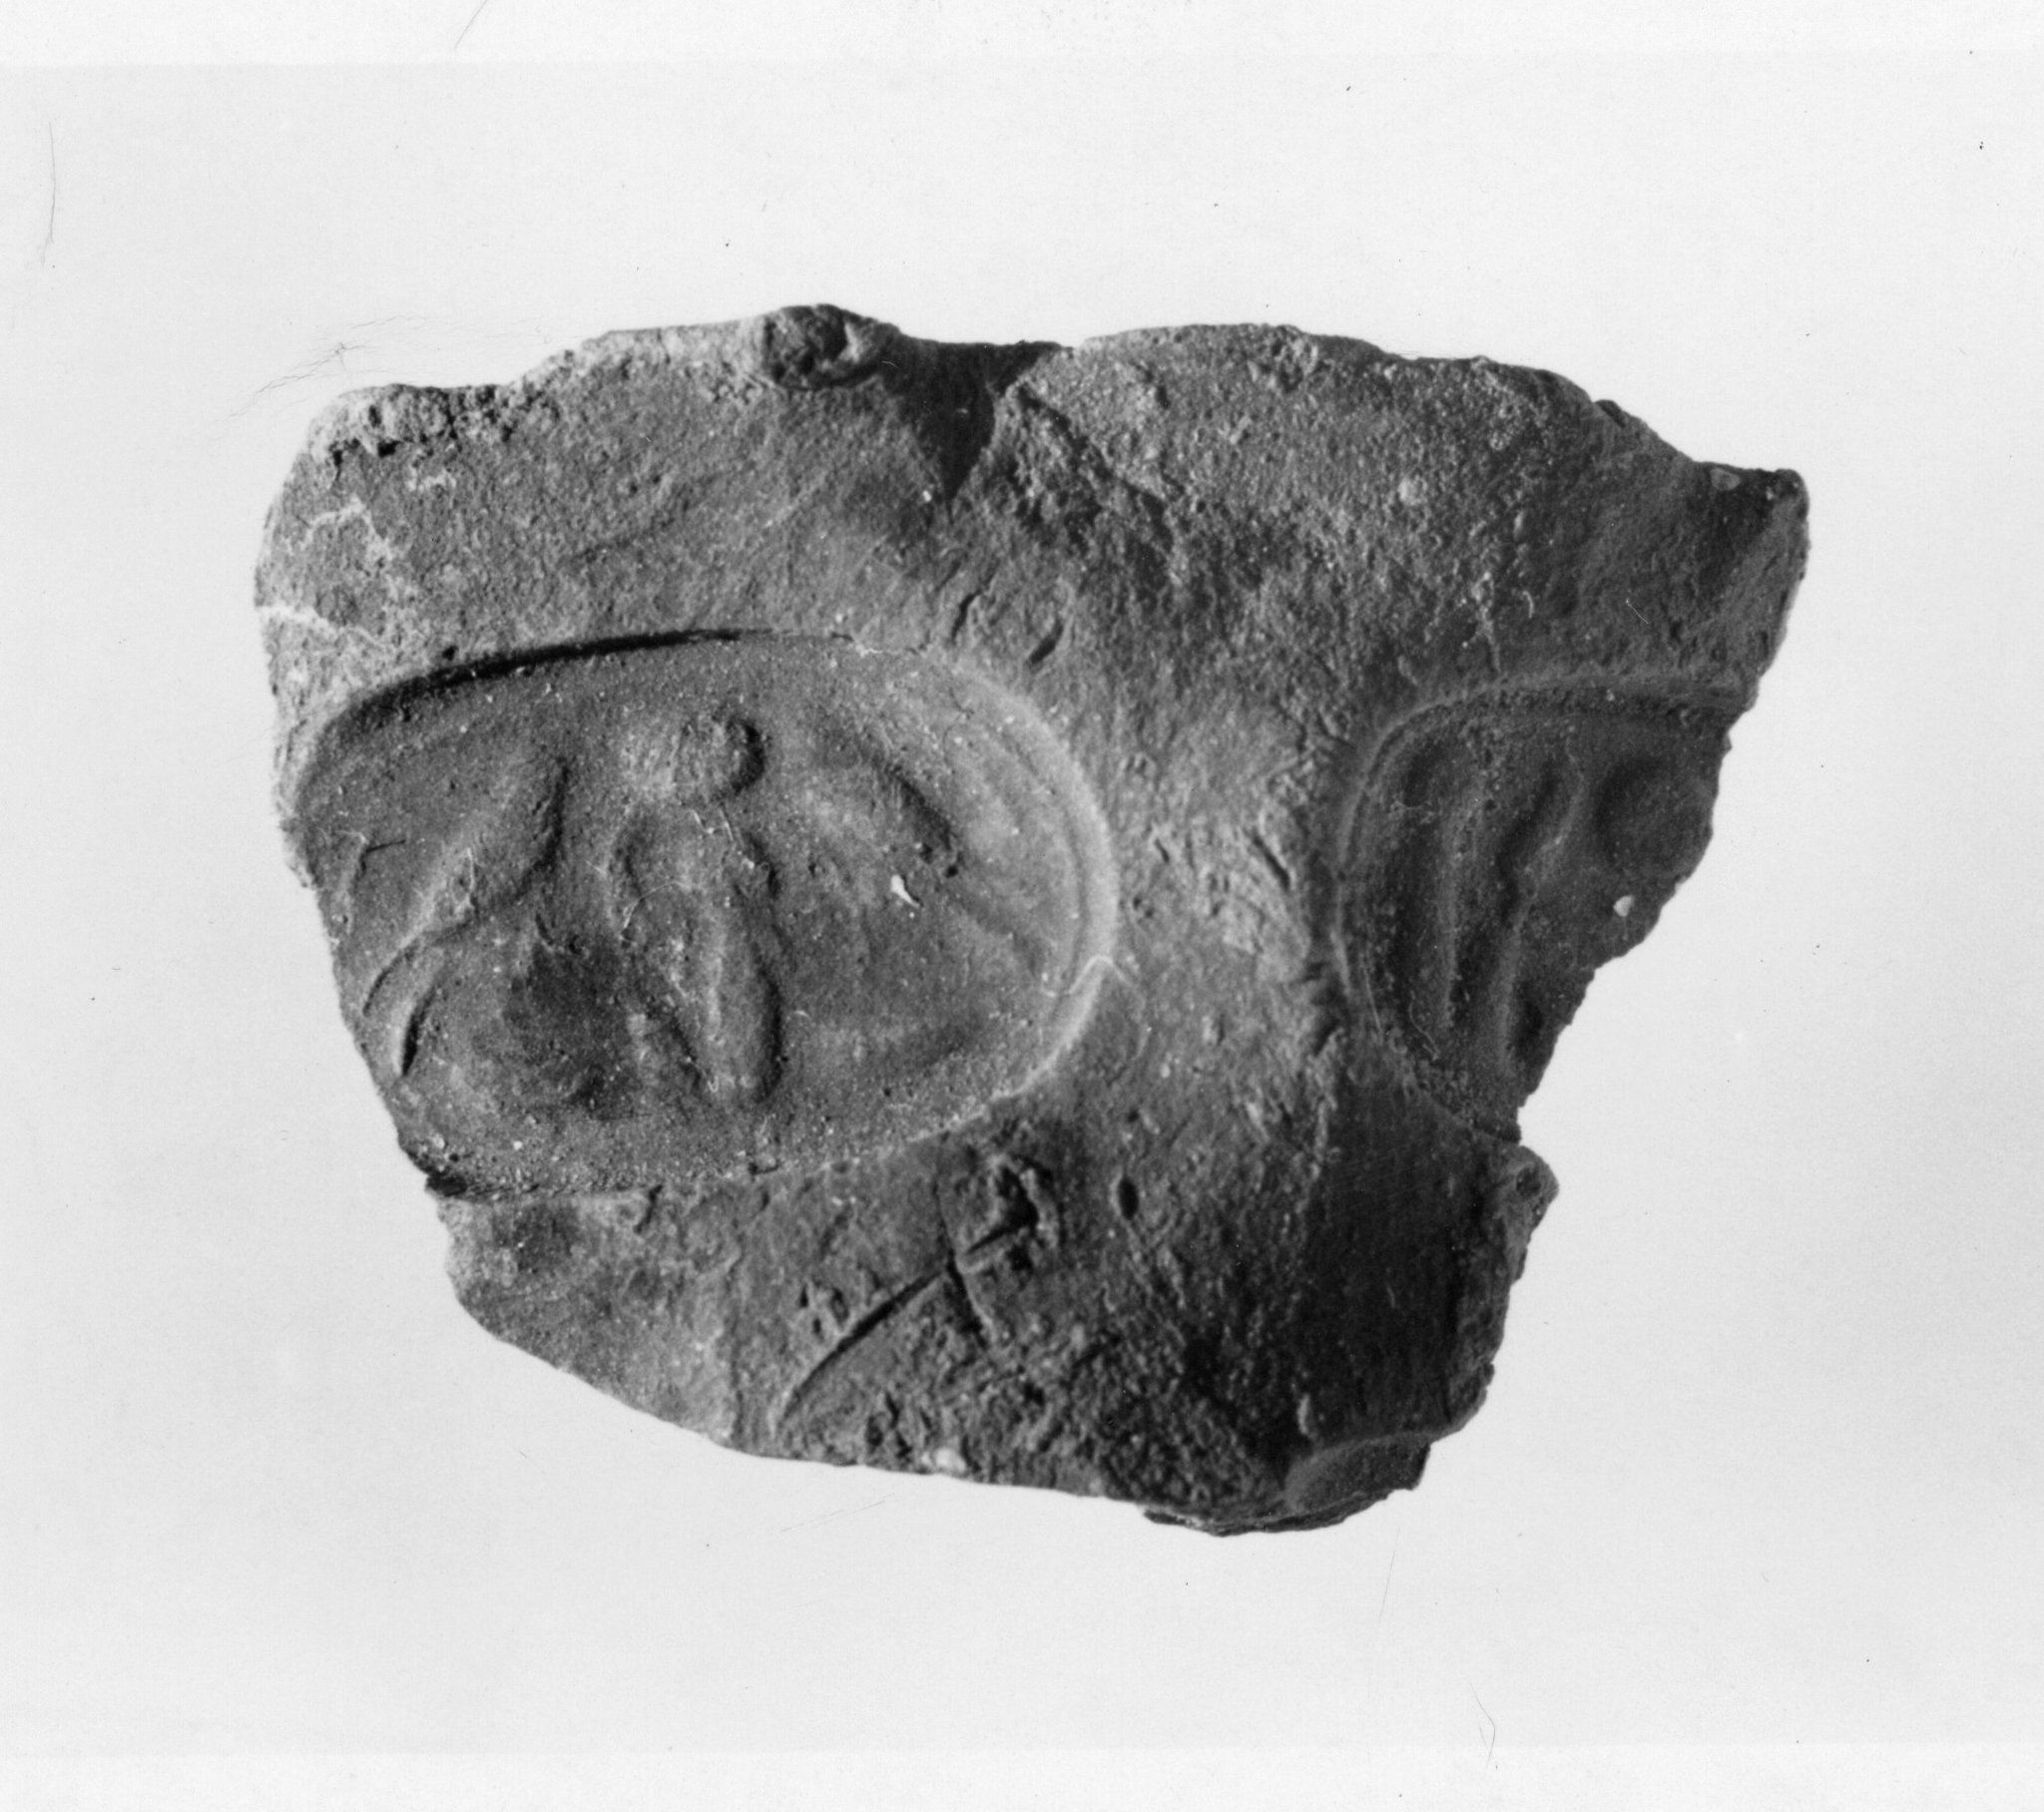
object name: sealing, nebmaatre, amenhotep iii,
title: Document Sealing With Multiple Seal Impressions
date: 1390-1352 BCE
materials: mud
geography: egypt